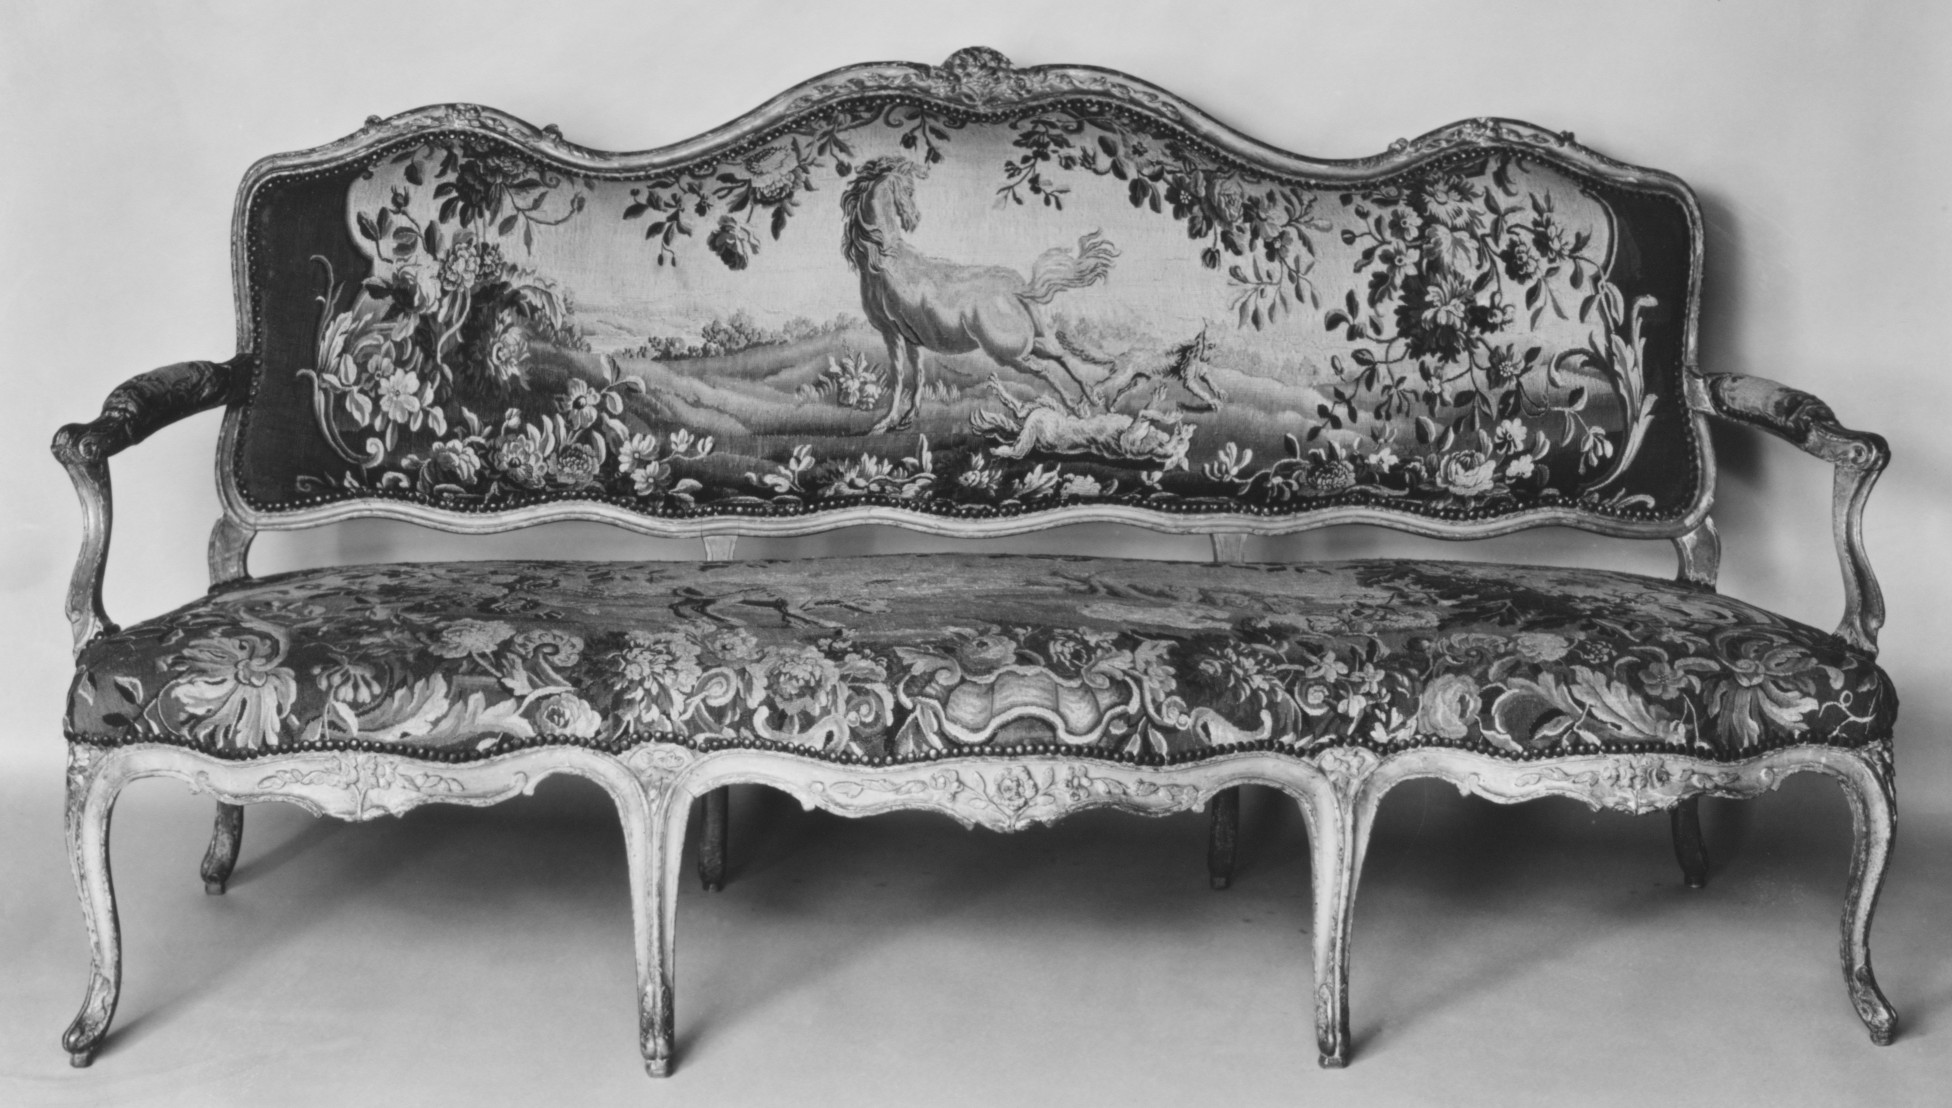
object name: sofa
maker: aubusson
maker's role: factory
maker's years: 1665-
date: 1734-1766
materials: silk, wood, wool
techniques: carving, painting, tapestry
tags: horses